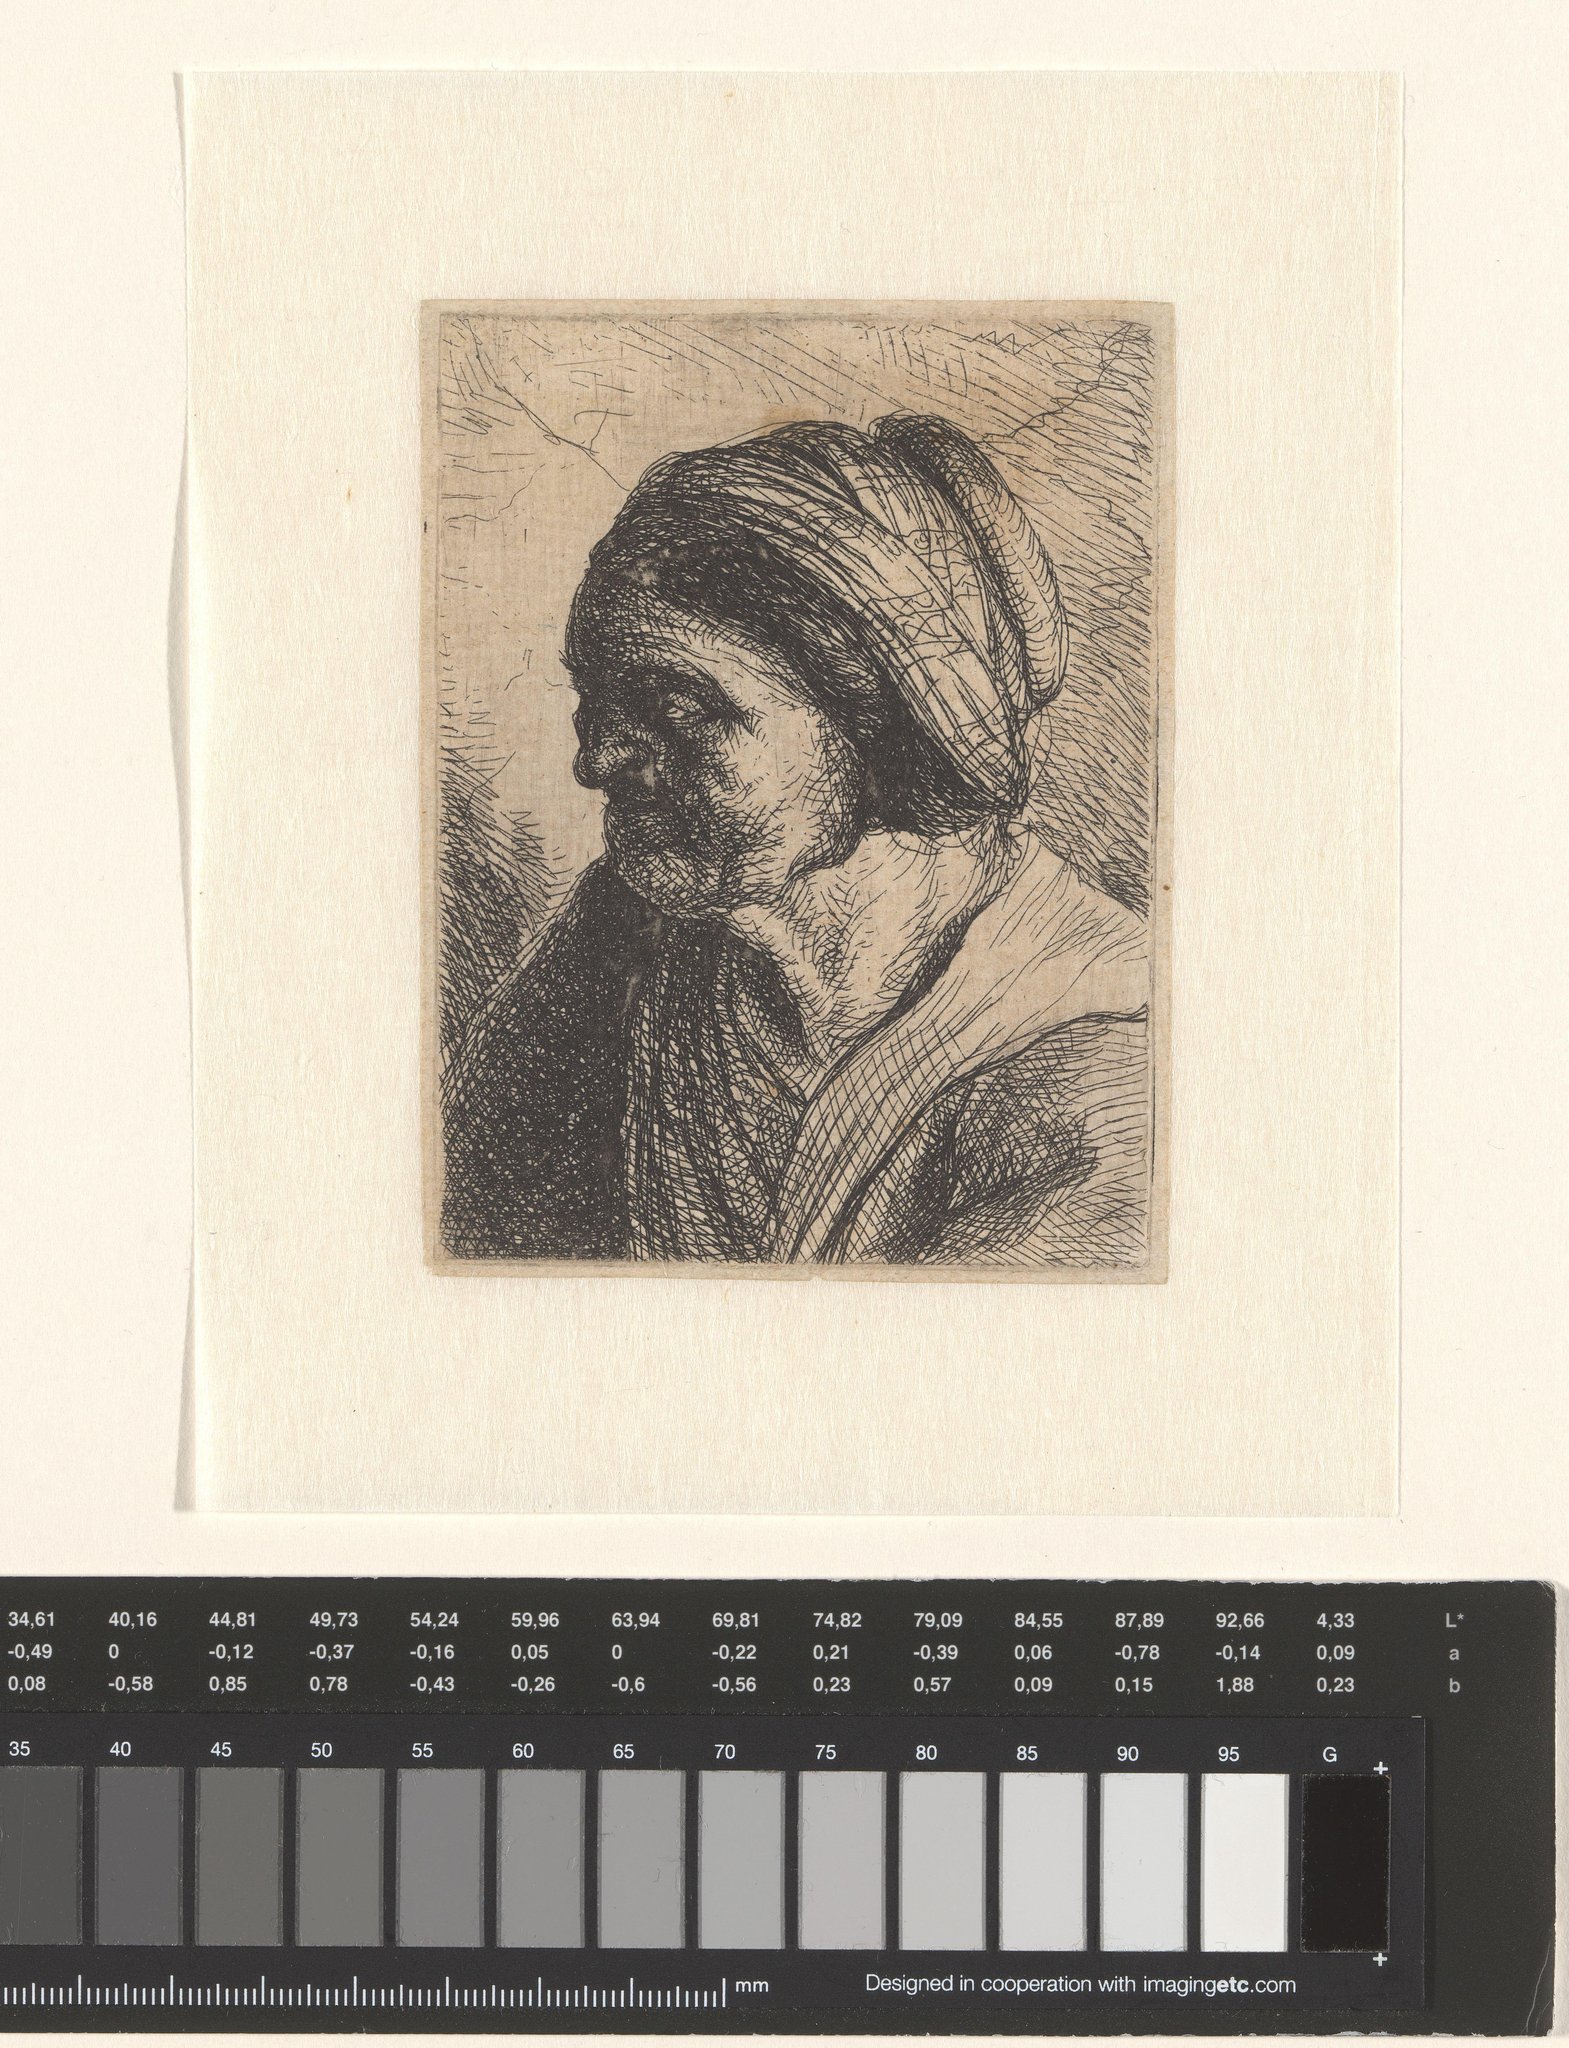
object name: print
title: Buste van een oude vrouw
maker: florent de la mare-richart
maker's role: painter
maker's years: 1630-1718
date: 1650-1680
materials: ink, paper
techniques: etching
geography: paris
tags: old woman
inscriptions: collector's mark: Lugt 2228, collector's mark: Lugt 2760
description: Het titelblad heeft als opschrift: ‘’Testes different De la Mare.’’ Op basis hiervan kan de reeks worden toegeschreven aan de Franse schilder en etser Florent de la Mare-Richart / Florent De Lamare-Richard (c. 1630-1718). De ets met vrouwentronie toont de vroege navolging van de tronies van Rembrandt en Lievens in Frankrijk.